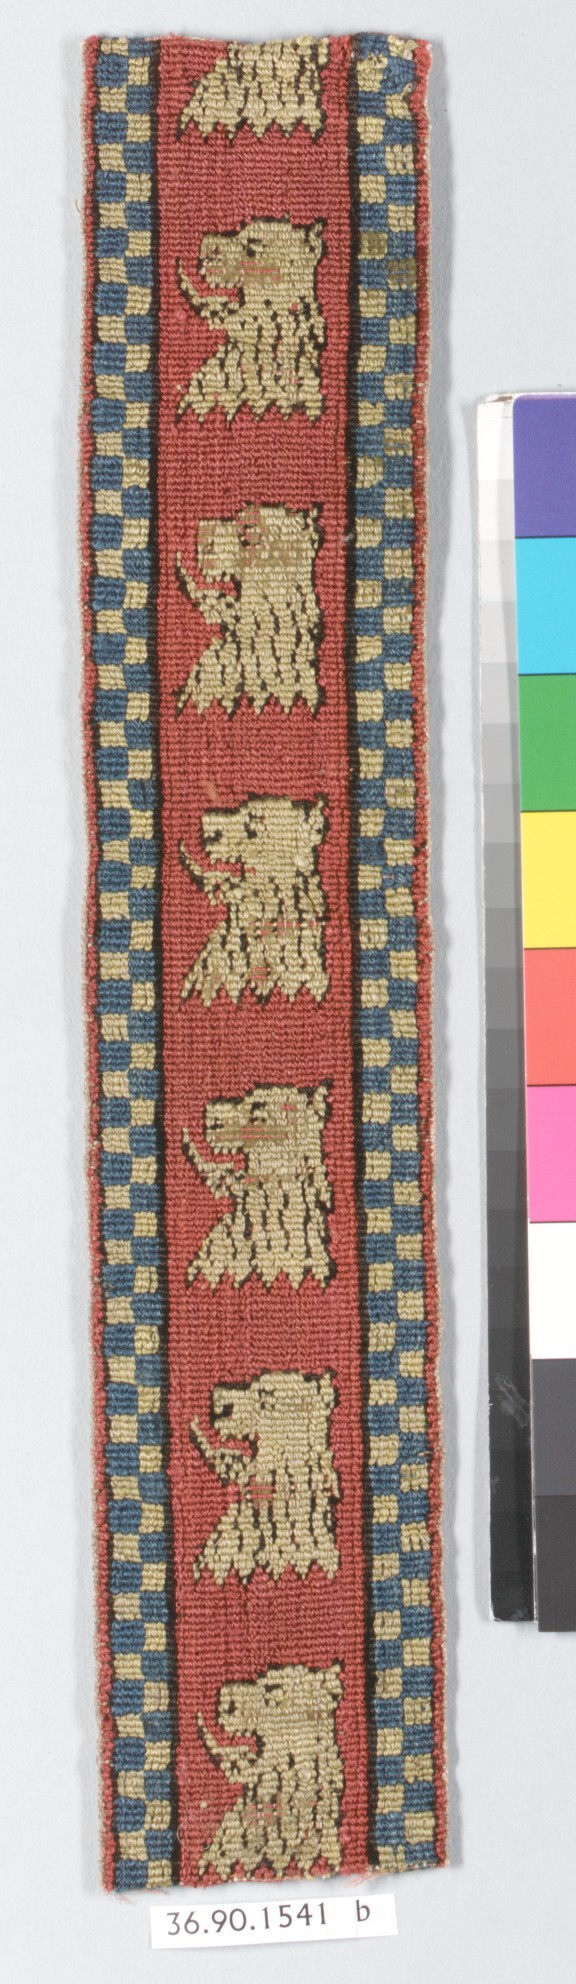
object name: galloon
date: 1701-1900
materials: wool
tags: animals